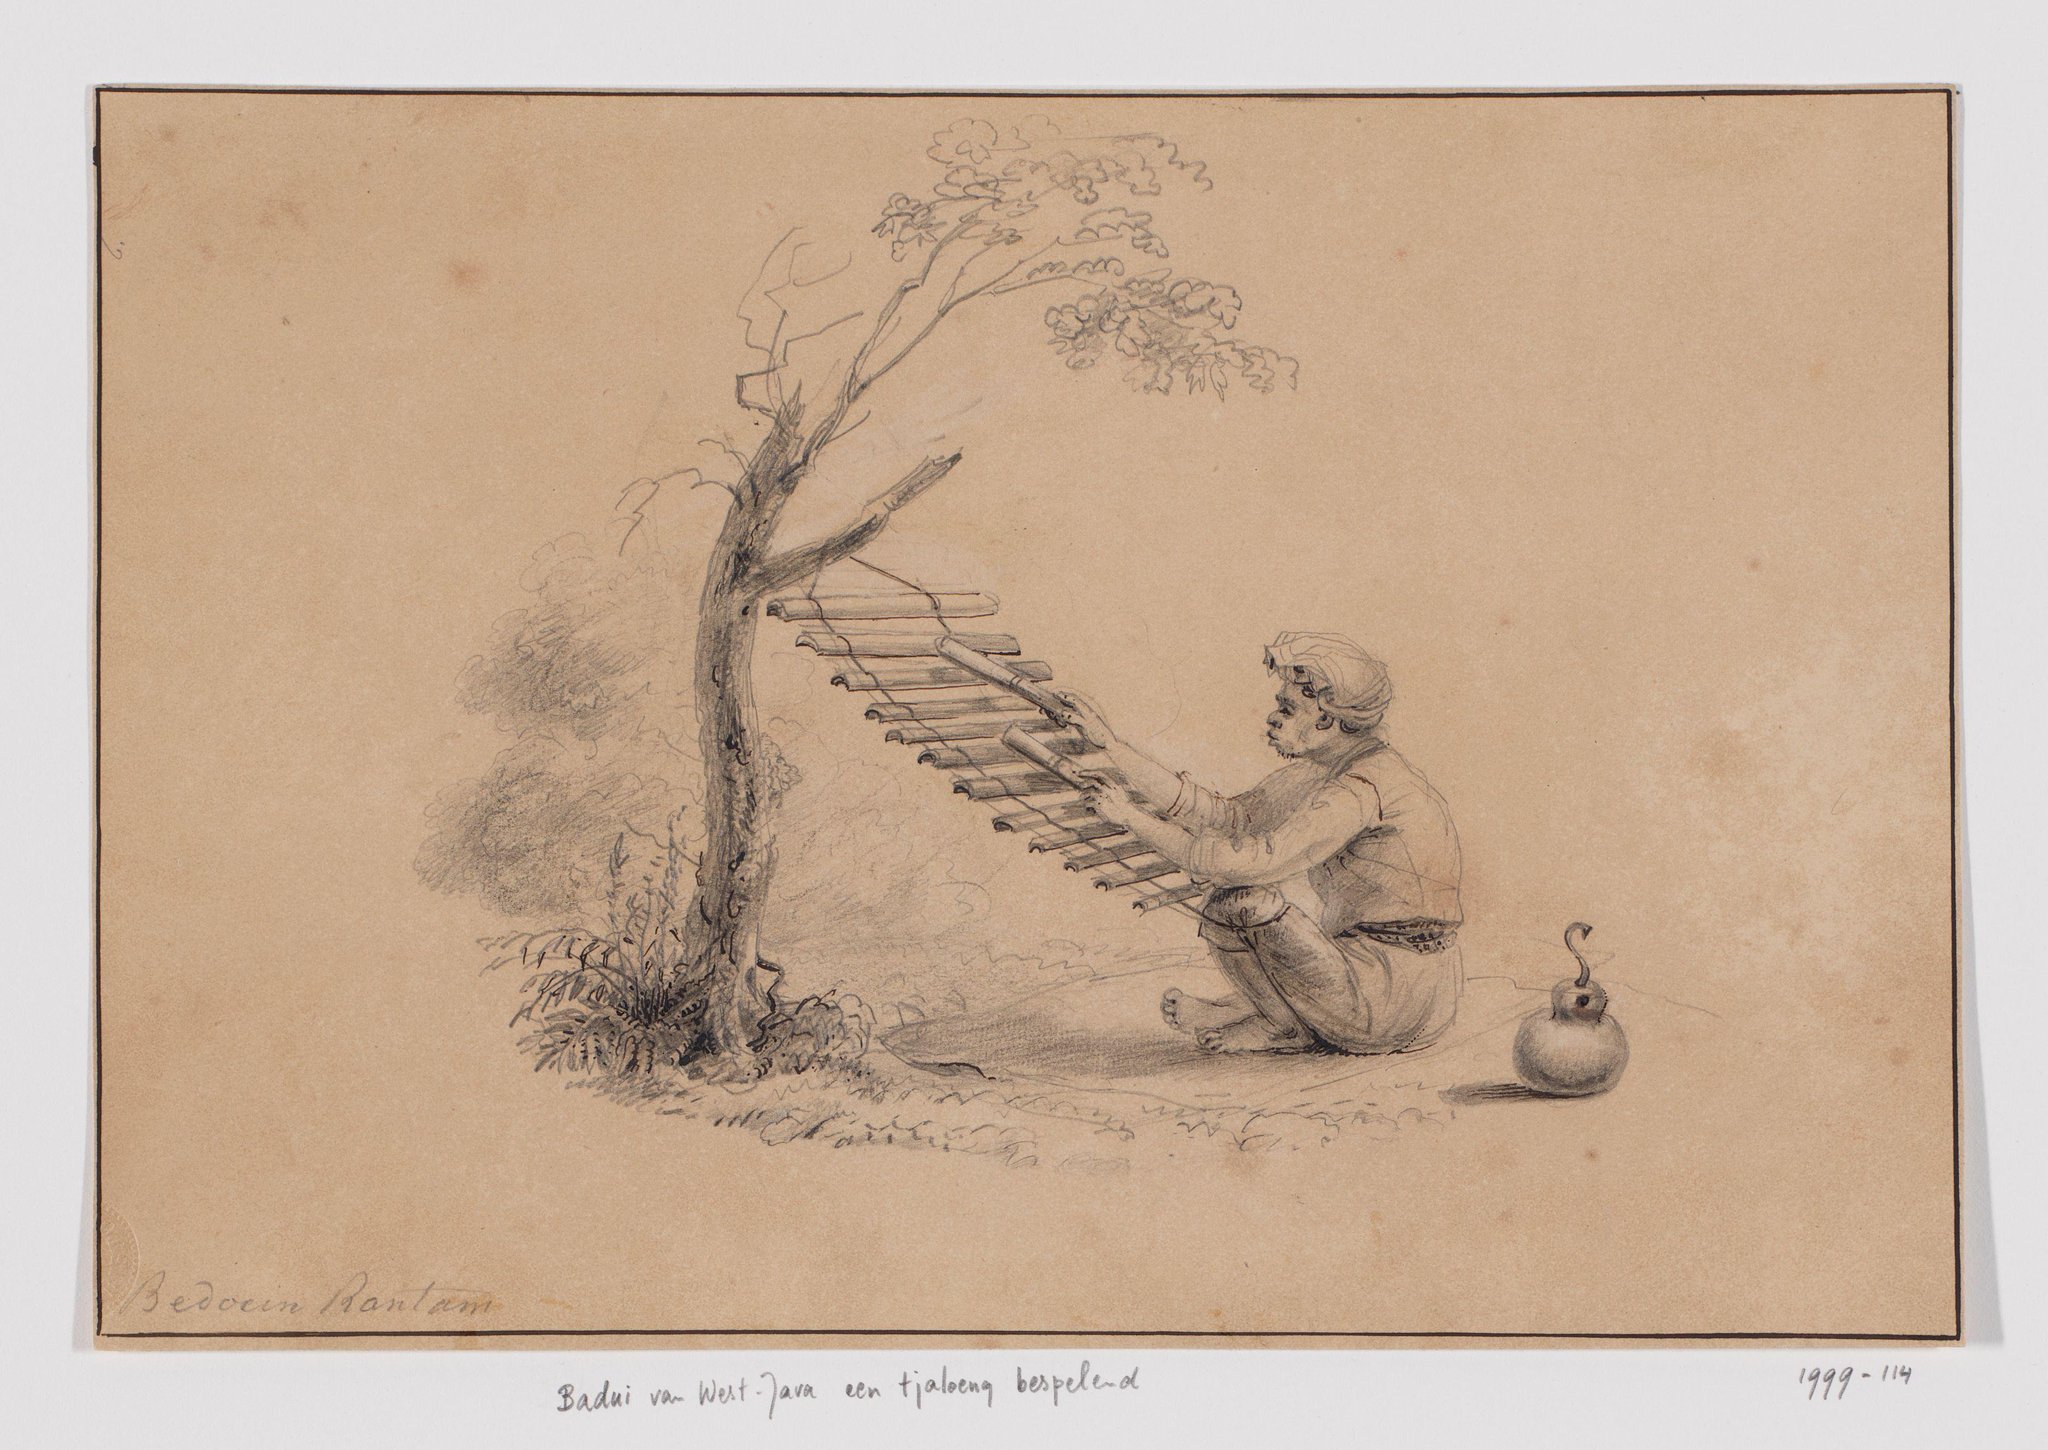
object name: drawing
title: Baduy van de residentie Banten, West-Java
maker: jannes theodorus bik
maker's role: draughtsman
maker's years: 1796-1872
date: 1816-1846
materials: board, ink, pencil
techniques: pen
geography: west java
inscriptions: inscription: ‘Bedoein Batam’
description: Baduy van de residentie Banten, een tjaloeng bespelend. De tjaloeng [calung] komt alleen in West-Java voor (de benaming is Soendanees). De Baduy wonen in het centraal bergachtig gedeelte van West-Java, gelegen ten westen van Bogor.